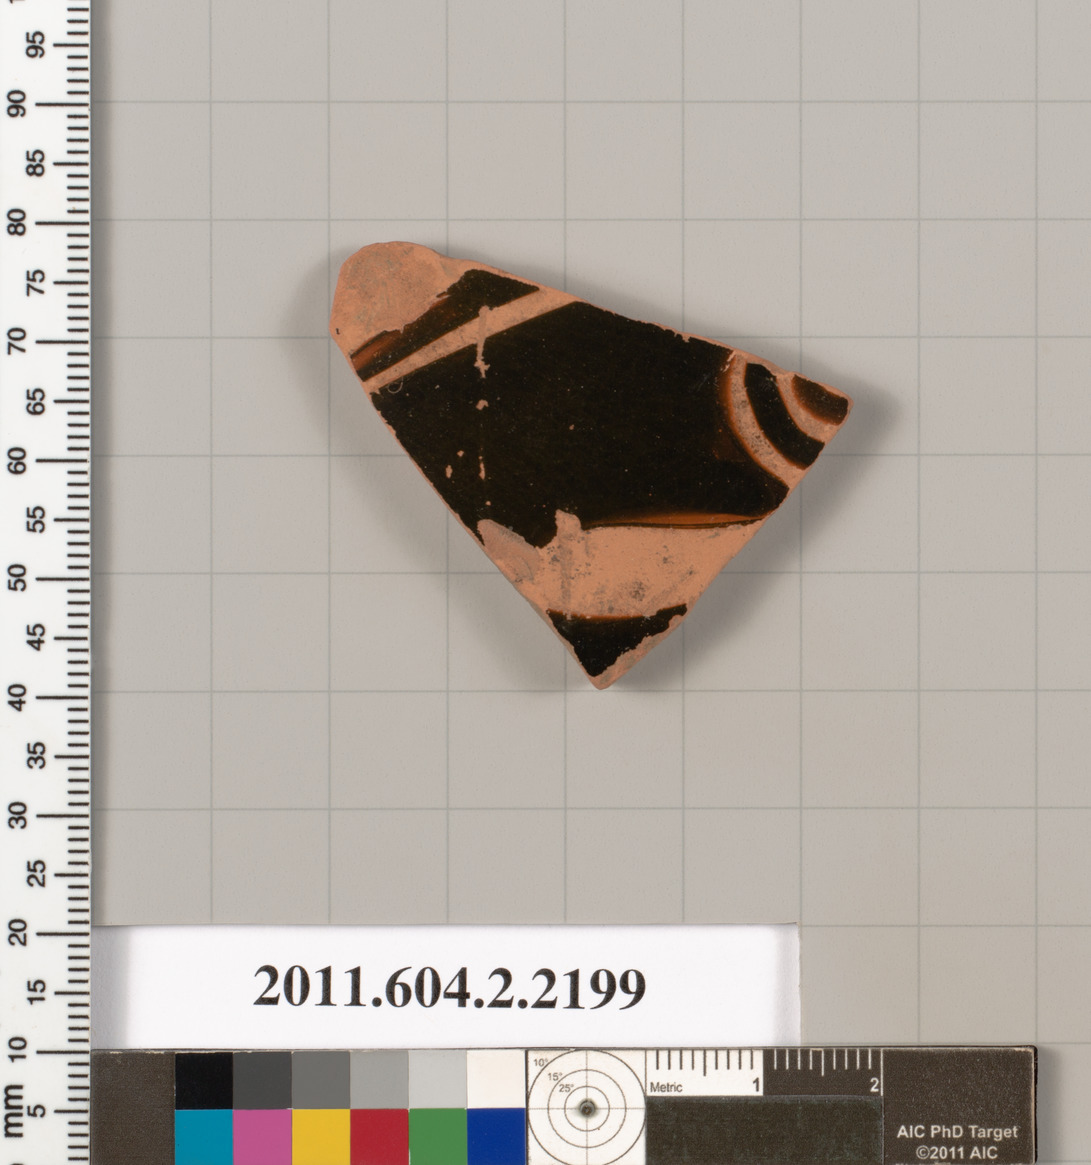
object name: pot fragment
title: Terracotta fragment of a pot; unglazed on the inside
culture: greek, attic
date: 450-426 BCE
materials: terracotta